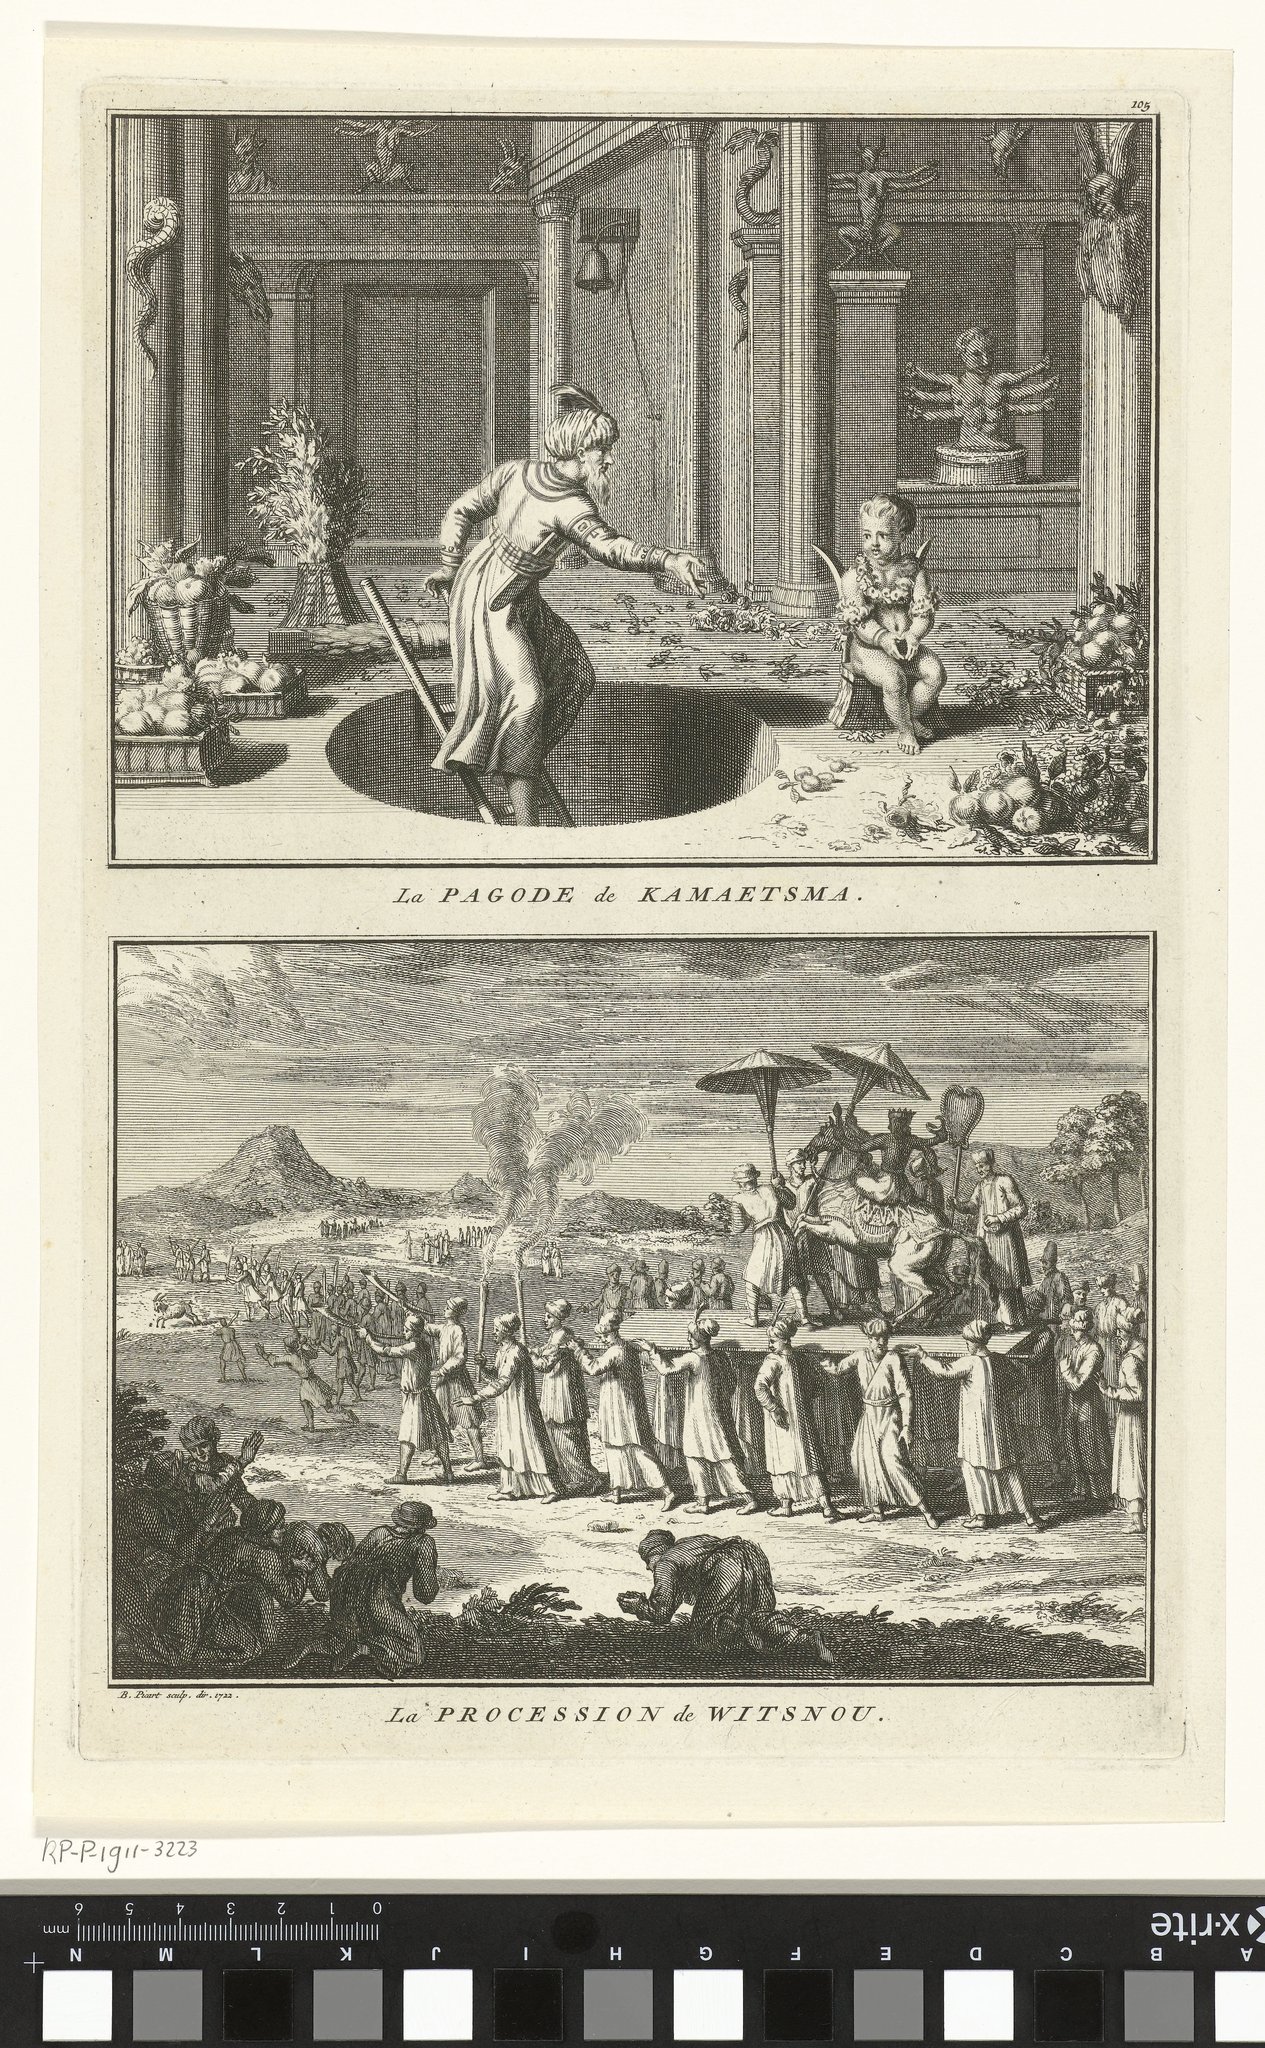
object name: book illustration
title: Voorstellingen van religieuze rituelen uit India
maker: bernard picart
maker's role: draughtsman, print maker, publisher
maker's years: 1673-1733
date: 1722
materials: paper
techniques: engraving, etching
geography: amsterdam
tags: temple, shrine ~ hinduism, buddhism, jainism, worship and devotion (in general) ~ hinduism, buddhism, jainism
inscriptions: collector's mark: Lugt 2228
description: Prent ook gebruikt in: Picart, Bernard. Naaukeurige beschryving der uitwendige godtsdienst-plichten, kerk-zeden en gewoontens van alle volkeren der waereldt, deel III. [Vertaald in het Nederlands door] Moubach, Abraham. Den Haag, Amsterdam, Rotterdam: Rutgert Alberts, Hermannus Uytwerf, Jan Daniel Beman, Isaac van der Kloot, 1727-1738. Prent waarschijnlijk ook gebruikt in: Ceremonies et coutumes religieuses des peuples idolatres, deel I. Amsterdam: Jean Frederic Bernard, 1723.